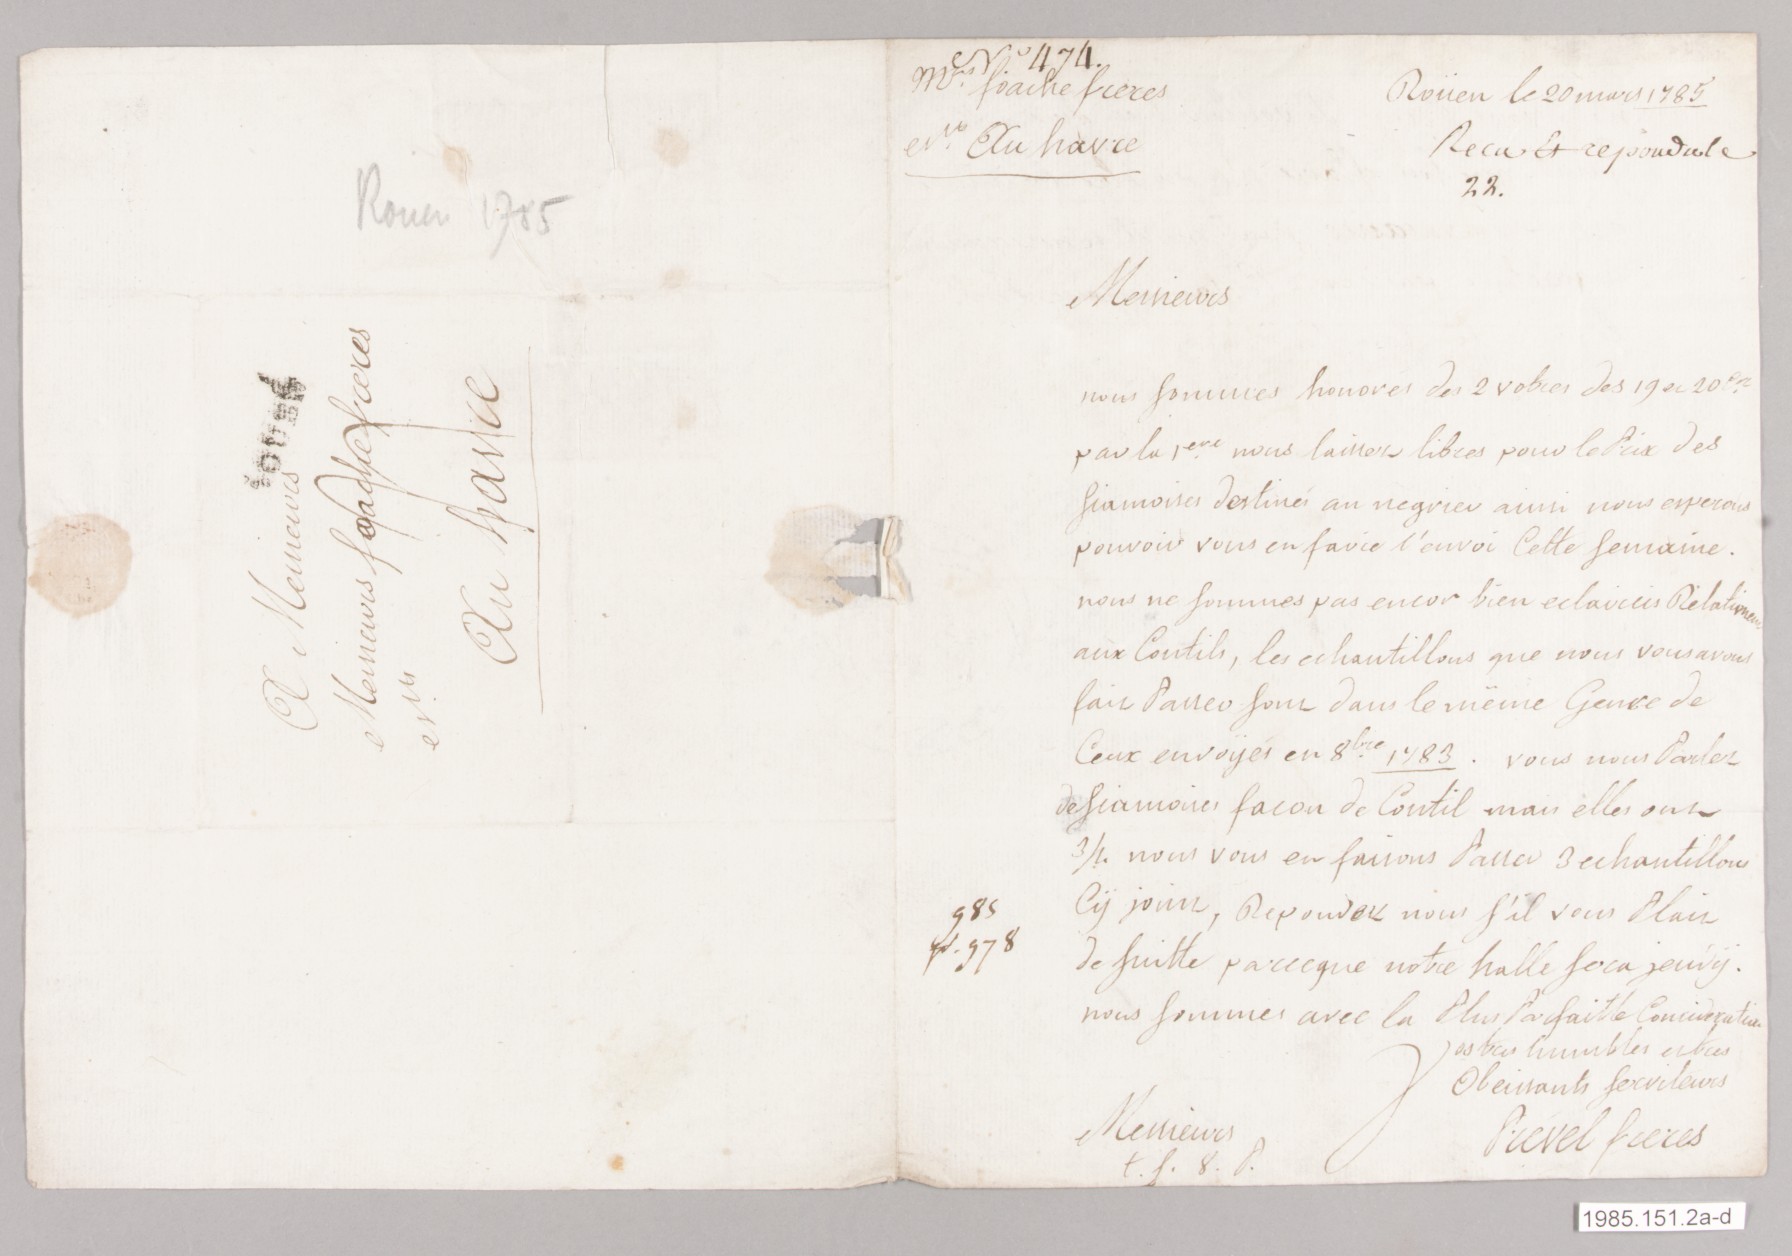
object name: sample and letter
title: Textile swatch to accompany letter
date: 1767-1800